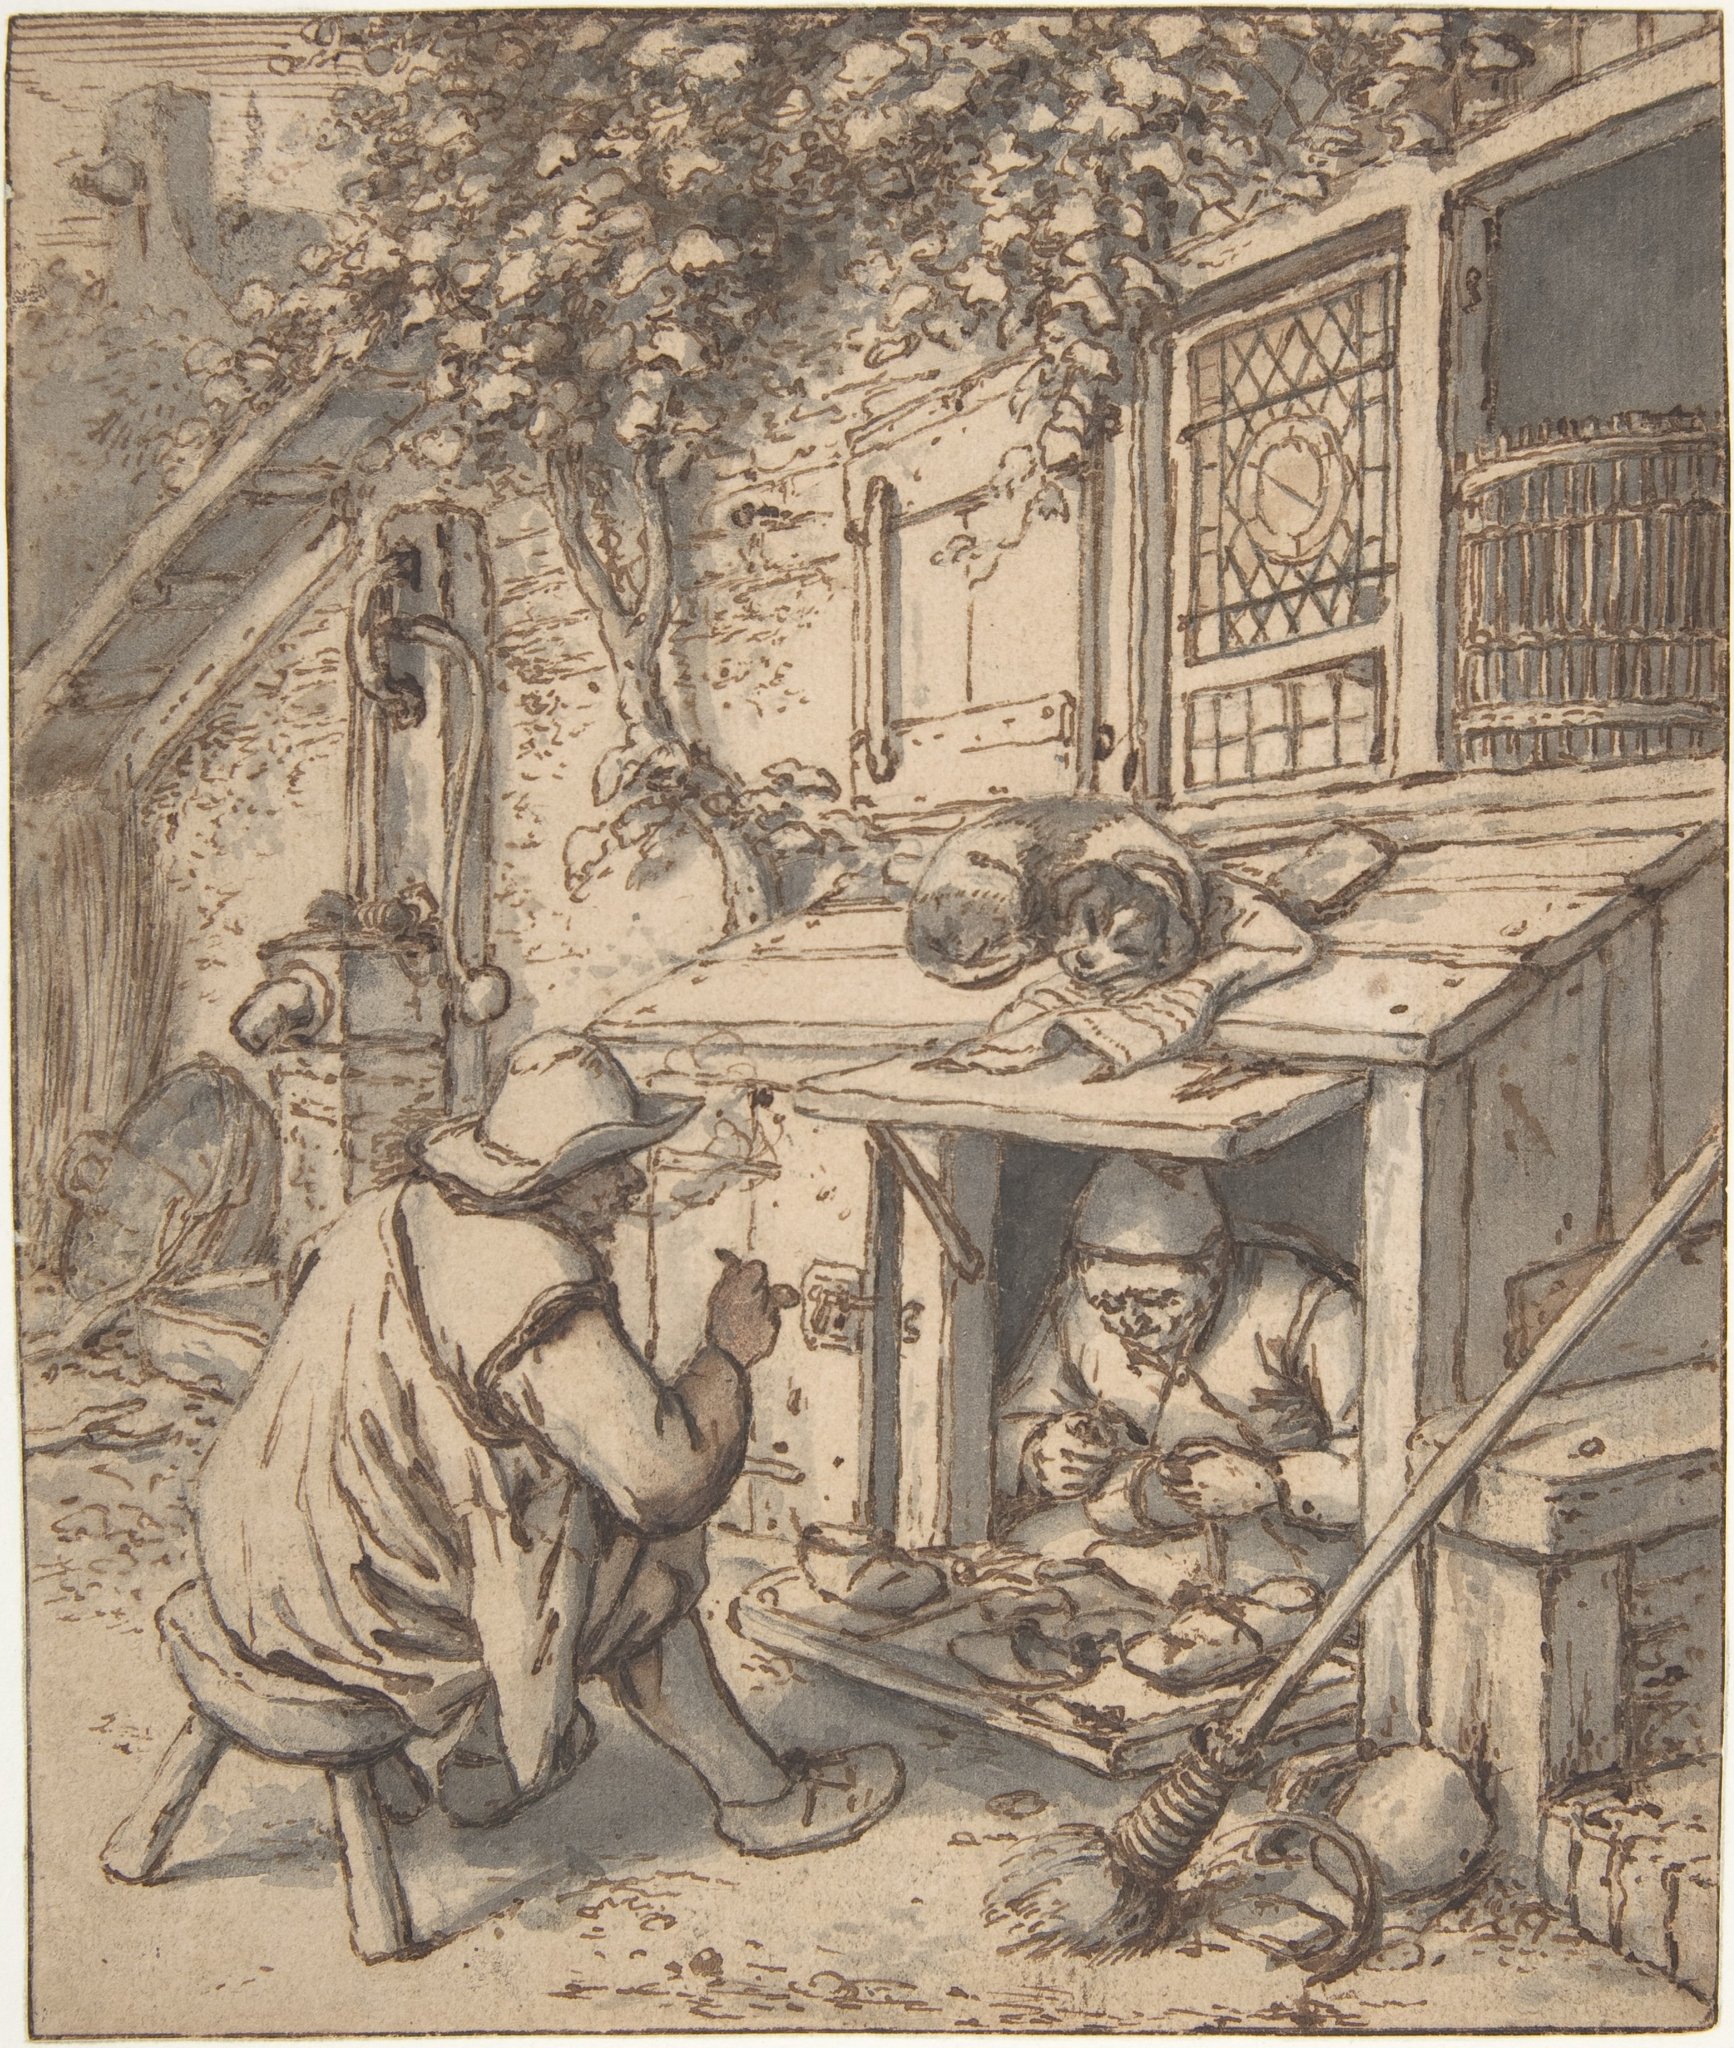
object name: drawing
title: The Cobbler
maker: adriaen van ostade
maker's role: artist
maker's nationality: dutch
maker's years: 1610-1685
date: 1601-1700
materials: graphite, ink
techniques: brush, incising, pen, transfer, drawing, wash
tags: shoes,men,dogs,working